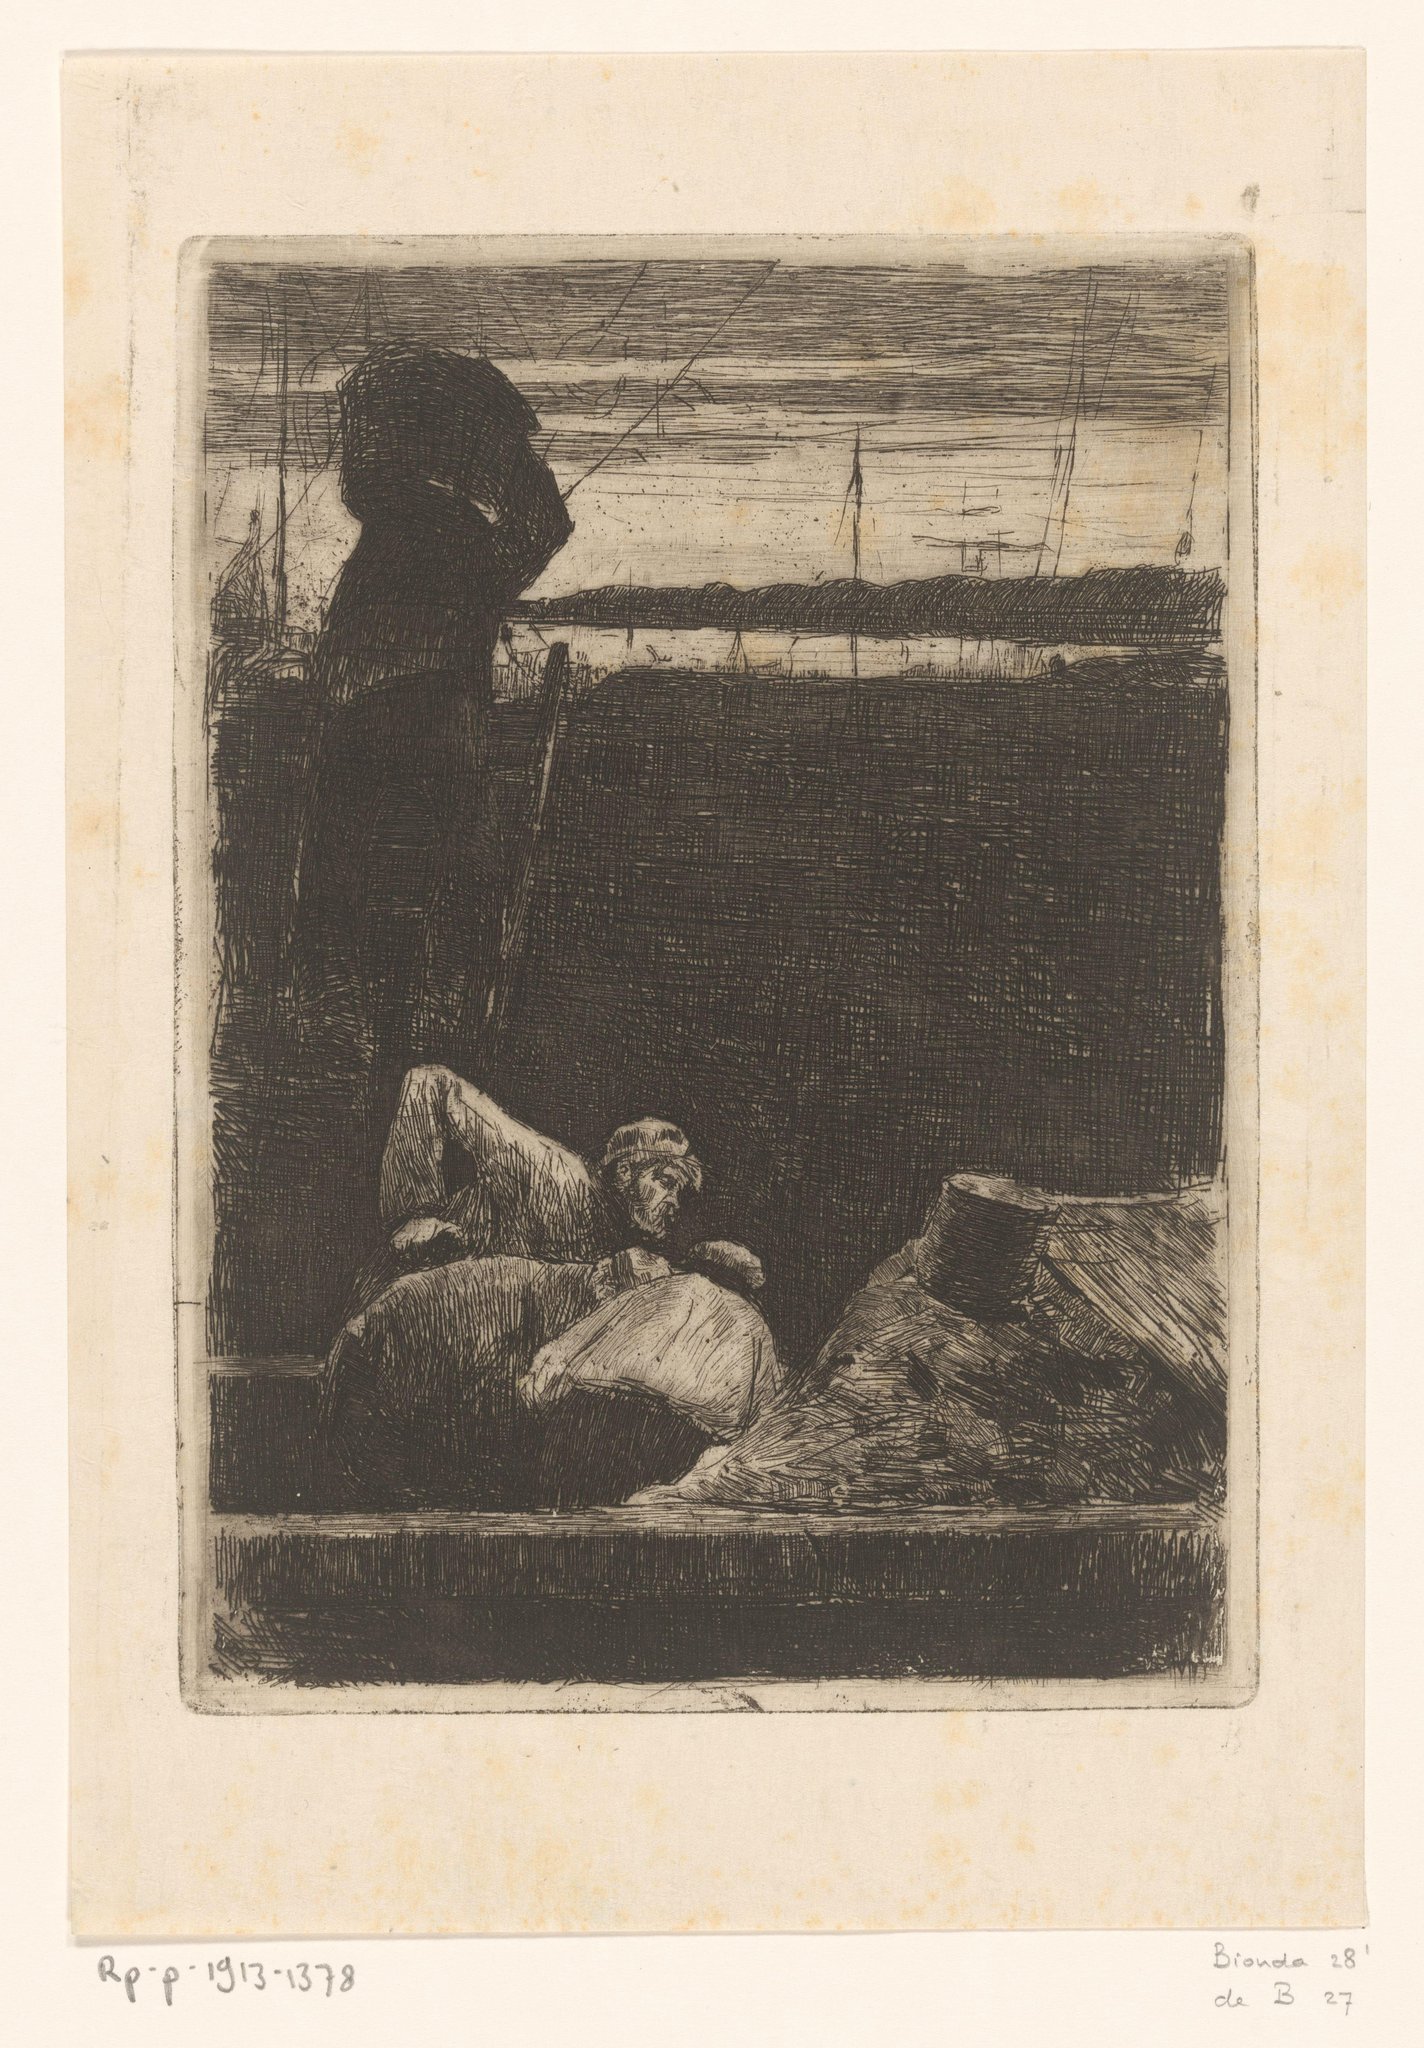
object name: print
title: Kolendragers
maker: willem de zwart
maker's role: draughtsman, painter, print maker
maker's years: 1862-1931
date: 1886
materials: paper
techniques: drypoint, etching, intaglio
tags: harbour, coal-shovel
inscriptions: collector's mark: Lugt 2233